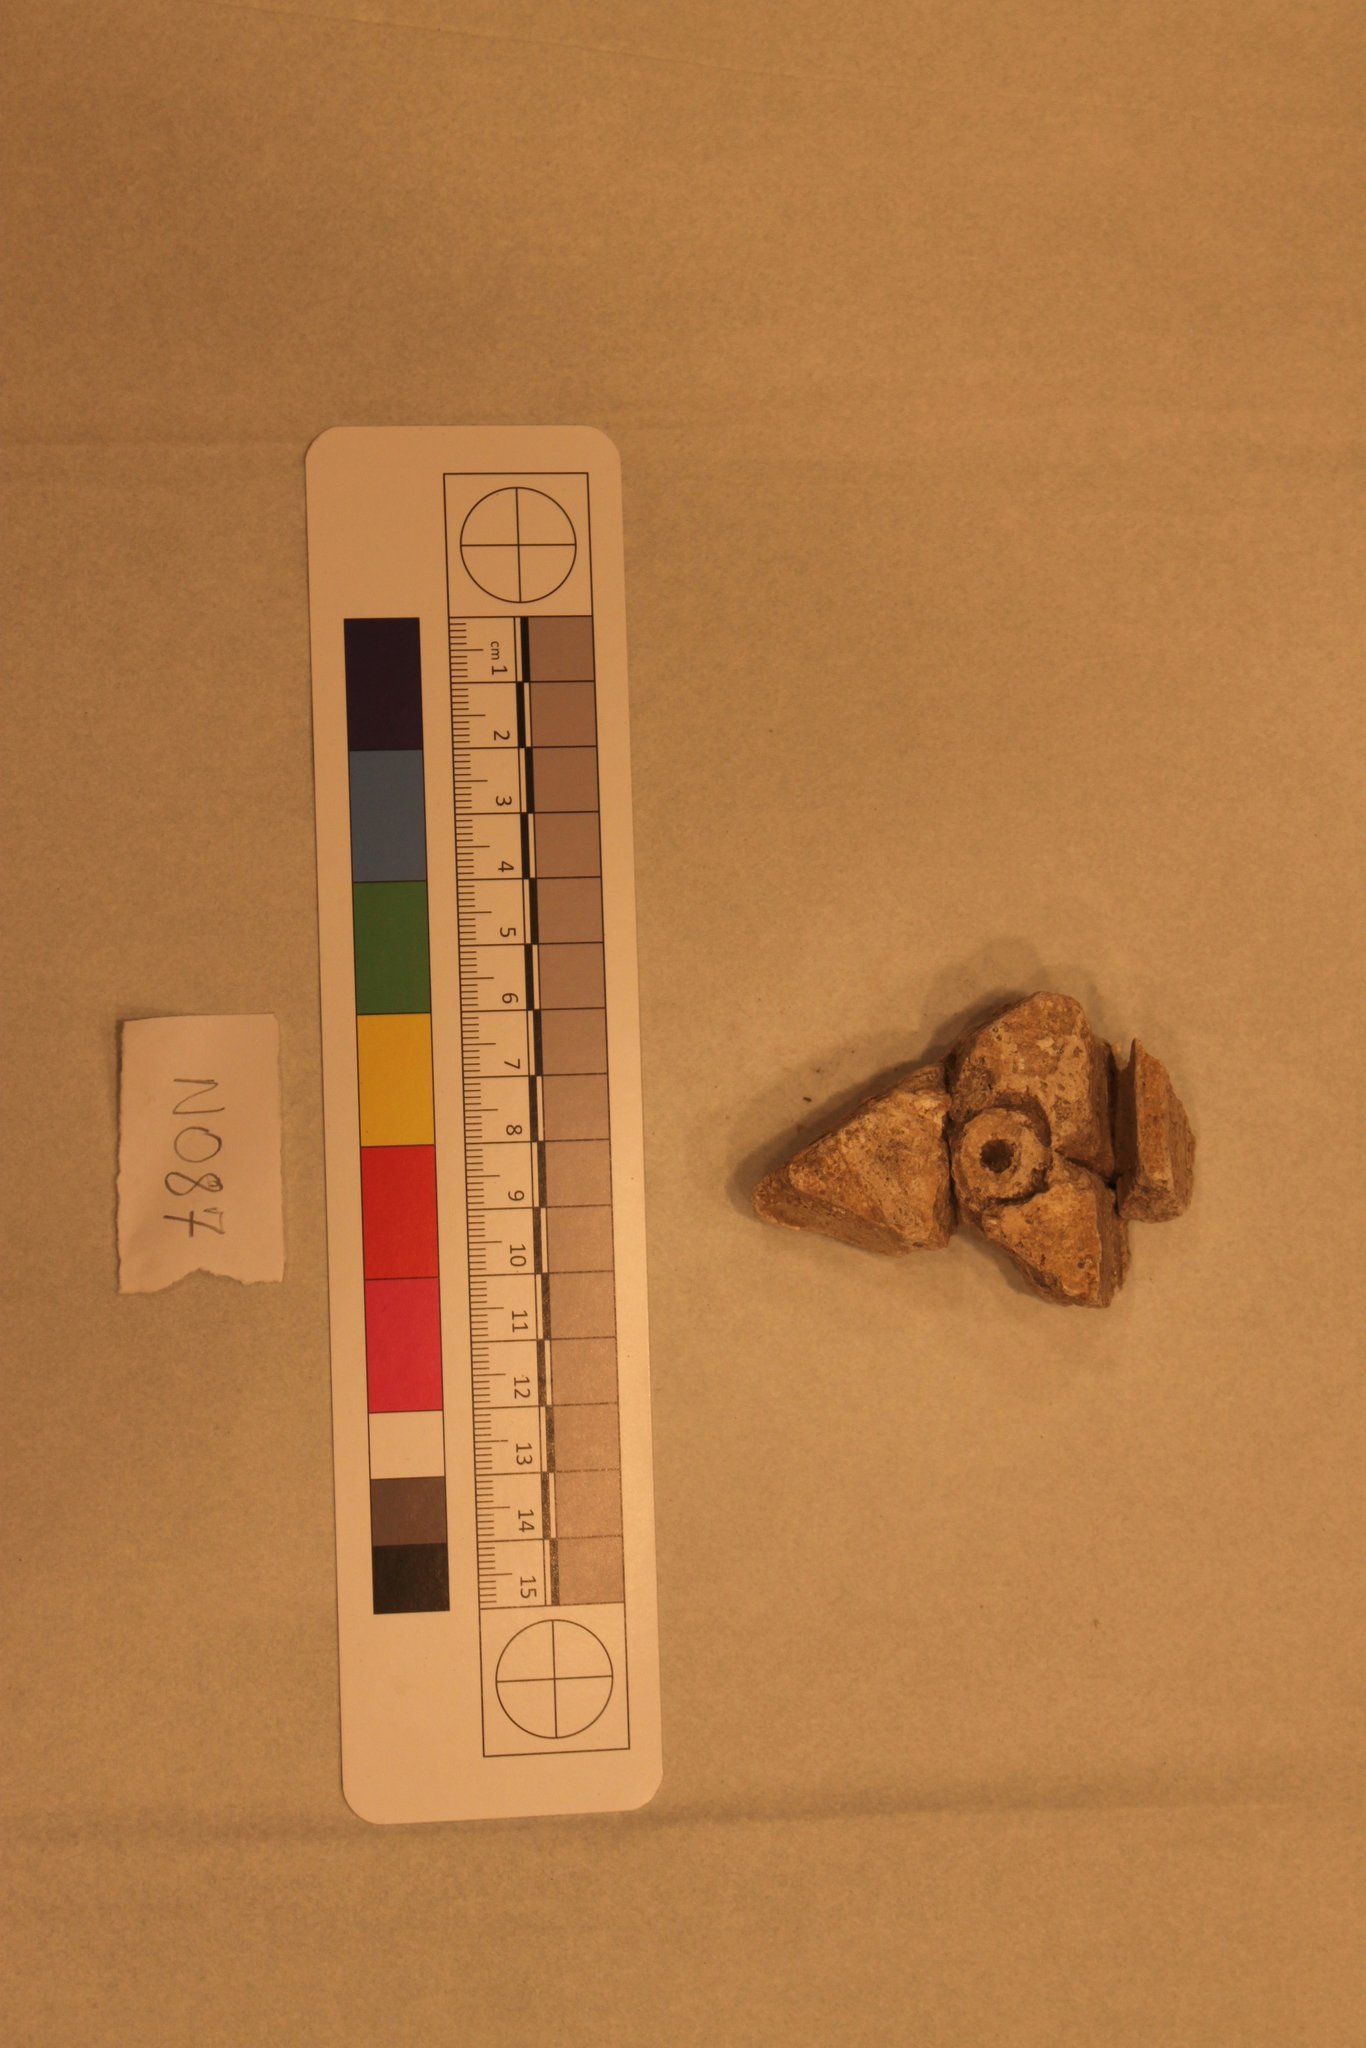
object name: fragment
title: Stucco Fragment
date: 701-1200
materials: plaster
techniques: carving, painting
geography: iran